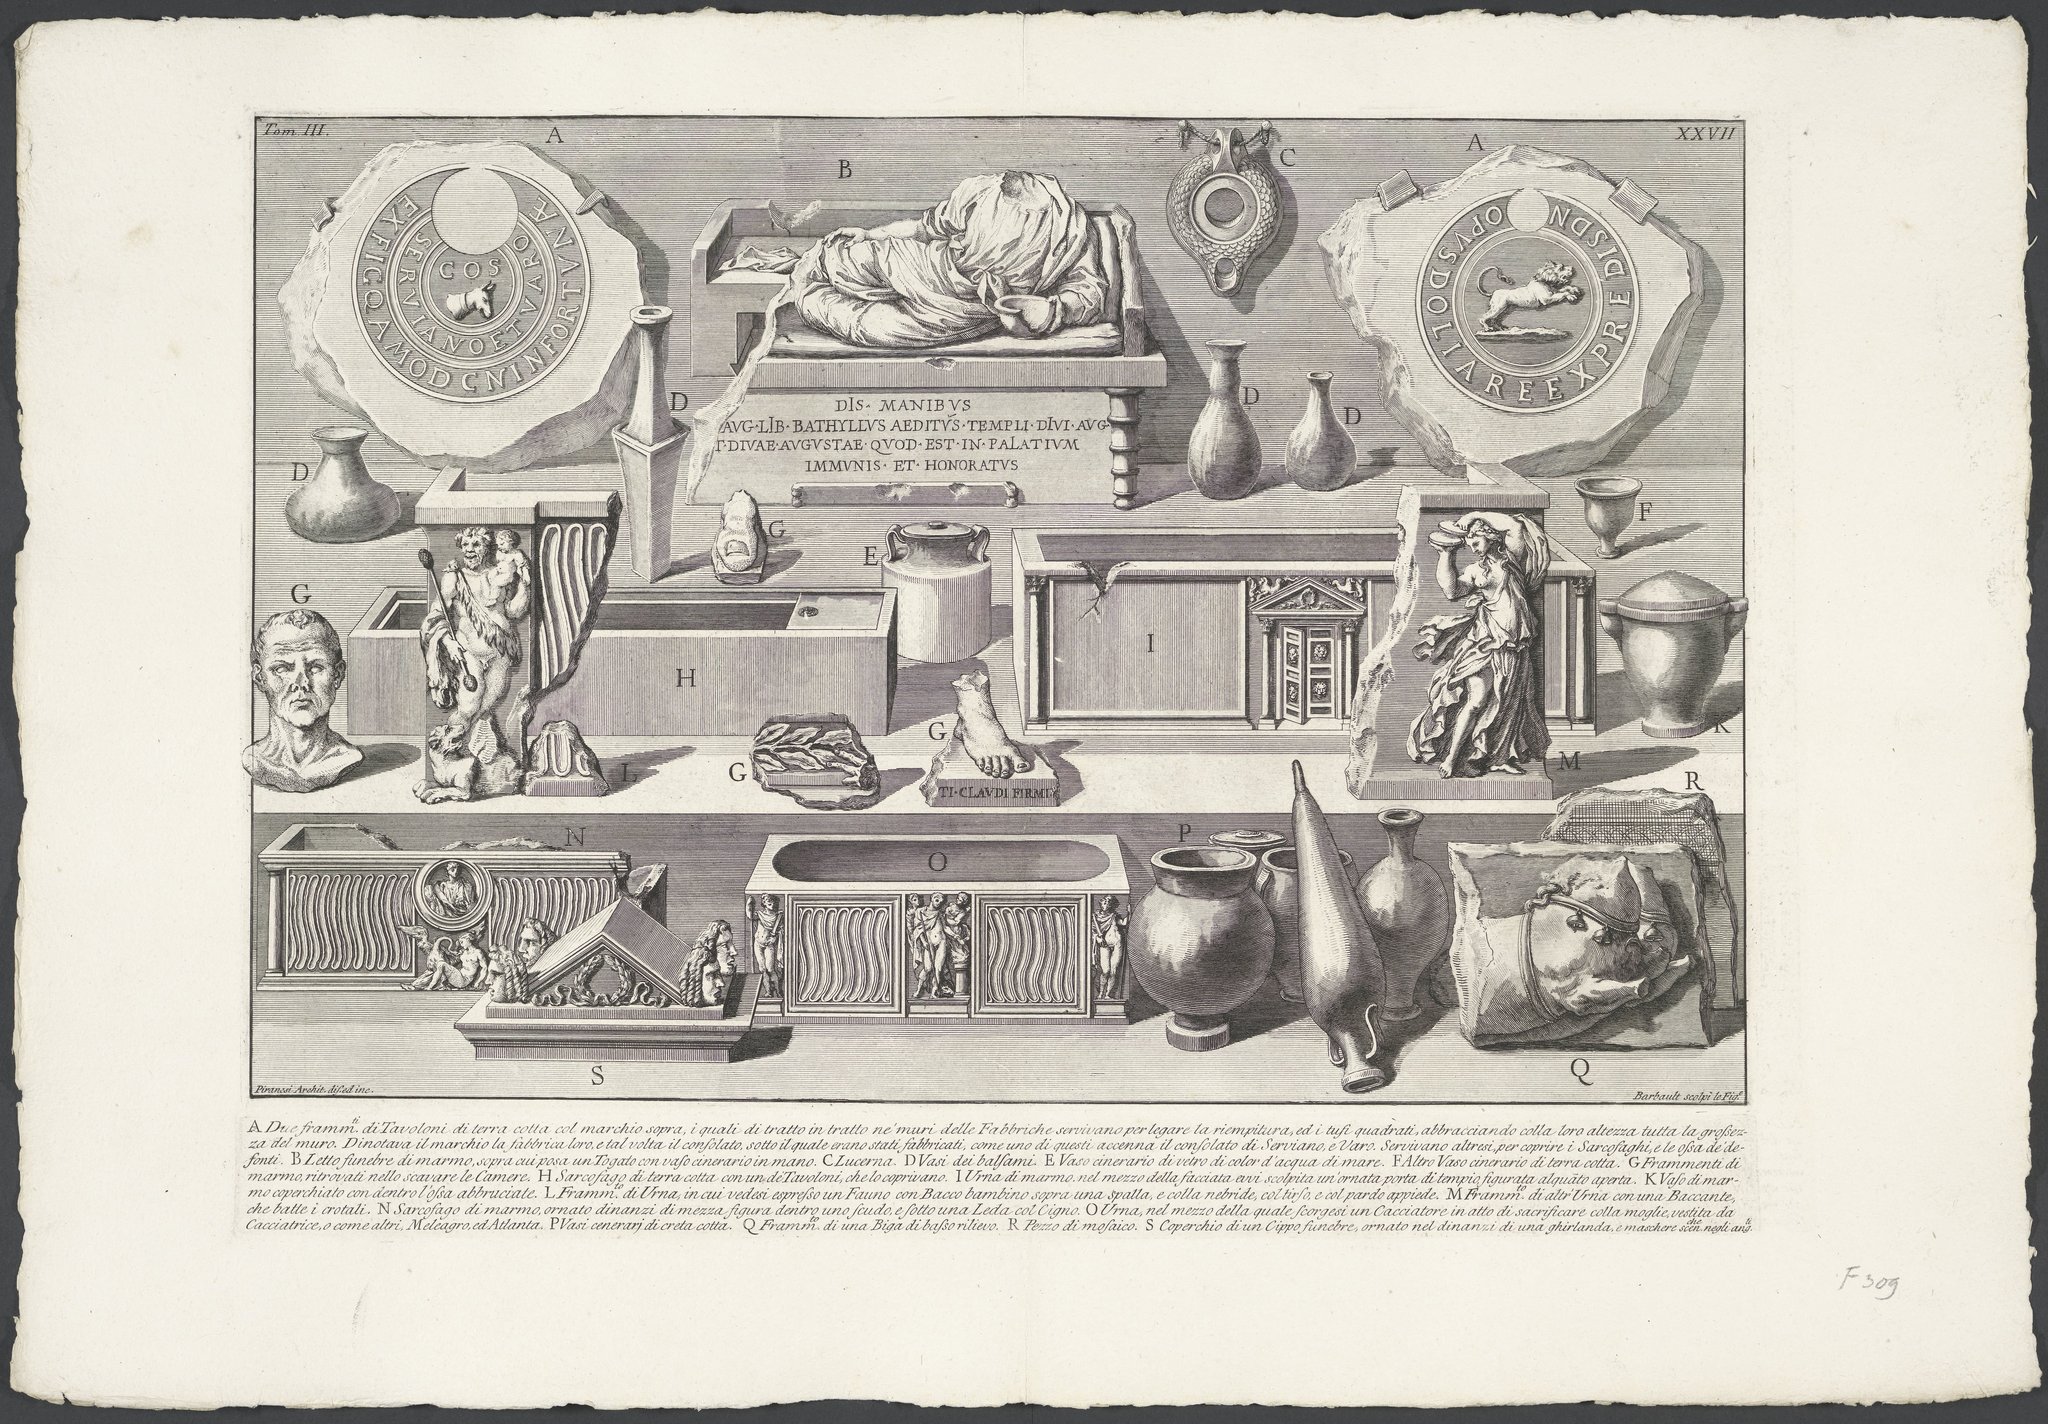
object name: print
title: Archeologische vondsten in en rond Rome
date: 1756-1757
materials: paper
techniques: etching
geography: italy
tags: piece of sculpture, reproduction of a piece of sculpture, sarcophagus, urn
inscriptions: collector's mark: Lugt 2228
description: Deze prent maakt deel uit van de serie 'Le Antichità Romane'. Piranesi deed meer dan acht jaar voorstudie voor deze 250 platen tellende serie die in vier volumes werd uitgegeven. Hij produceerde de prenten tussen ca. 1756 en 1757. De serie bevat ook prenten door of naar andere prentmakers, onder wie Francesco Bianchini en Girolamo Rossi.